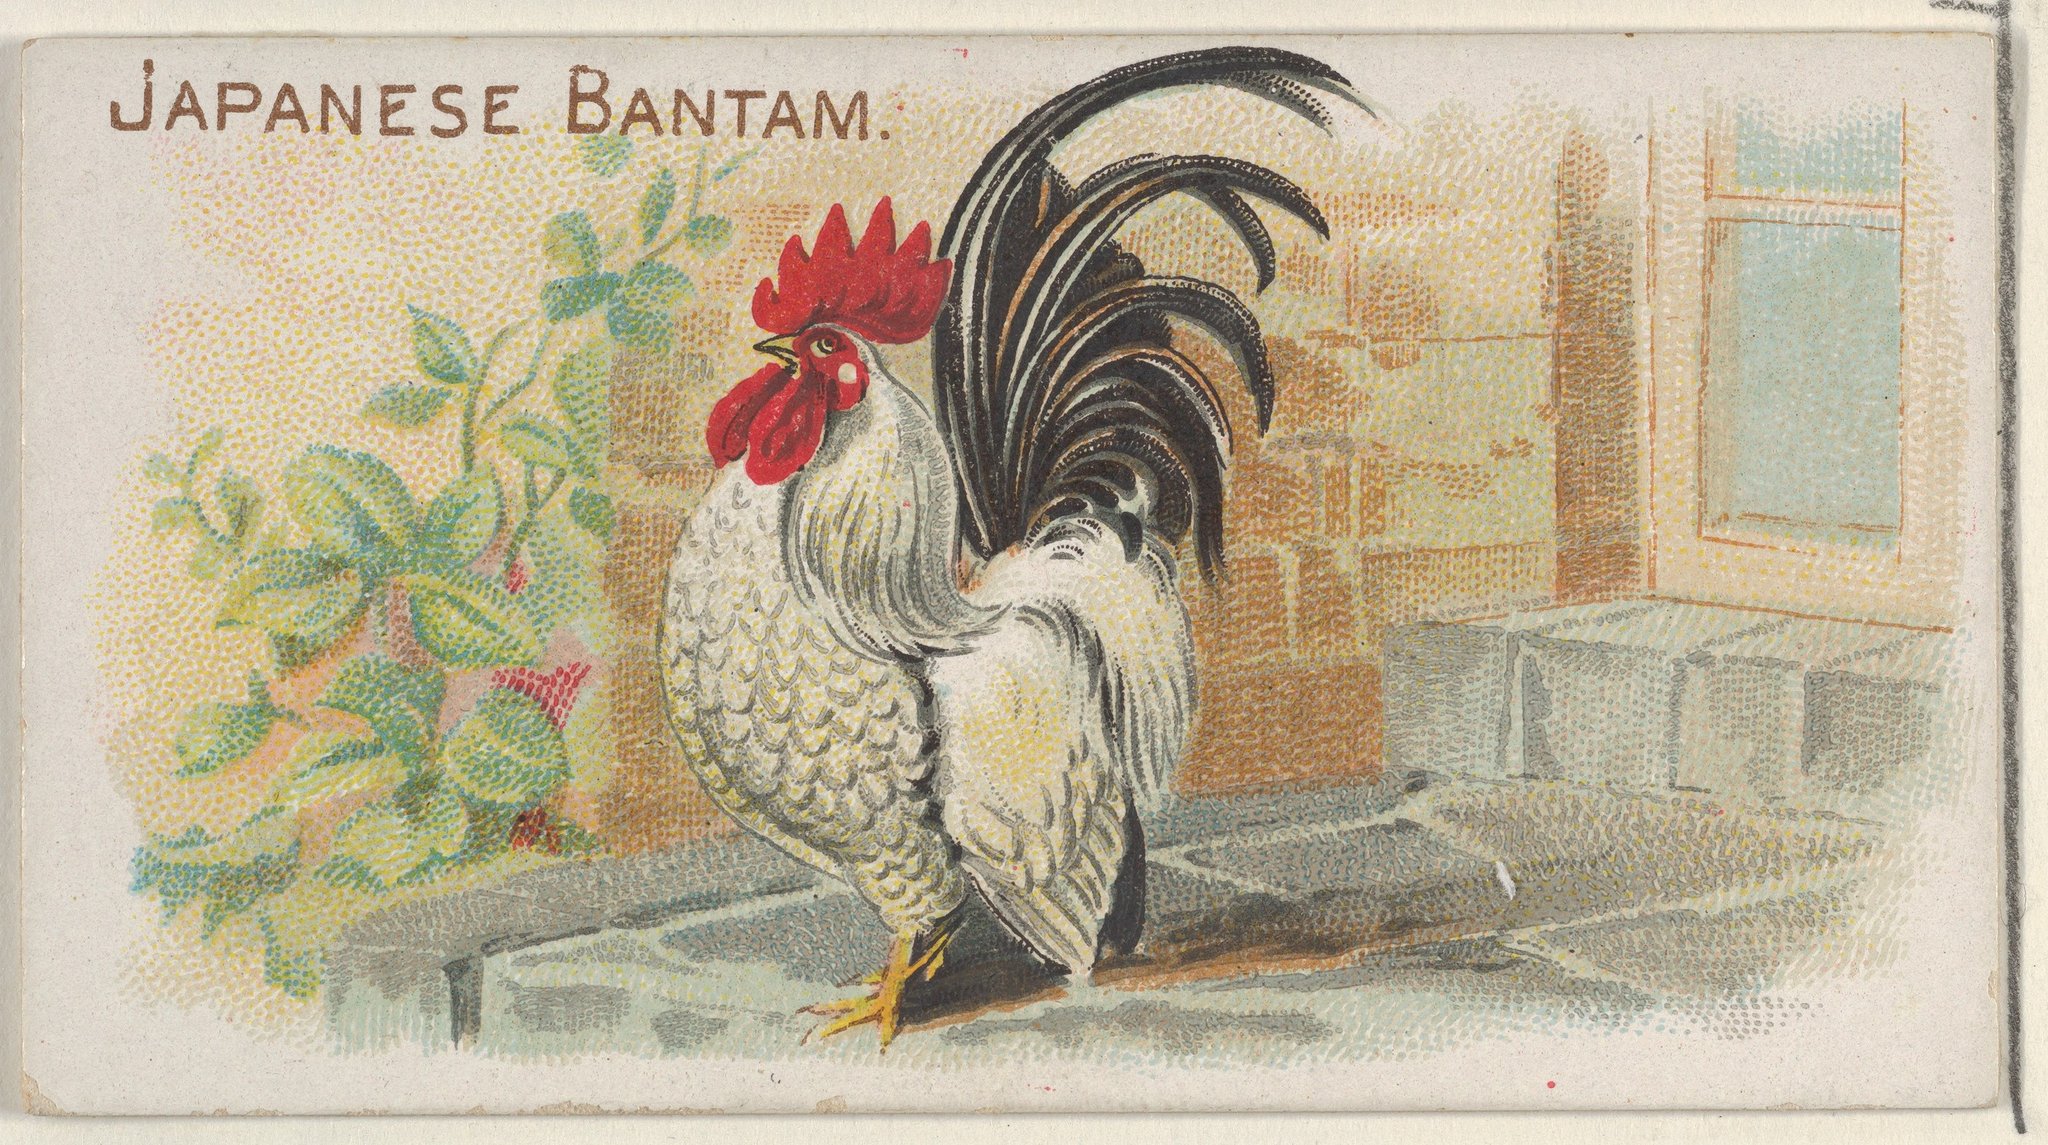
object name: print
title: Japanese Bantam, from the Prize and Game Chickens series (N20) for Allen & Ginter Cigarettes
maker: allen & ginter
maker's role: publisher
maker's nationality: american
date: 1891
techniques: color lithograph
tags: roosters